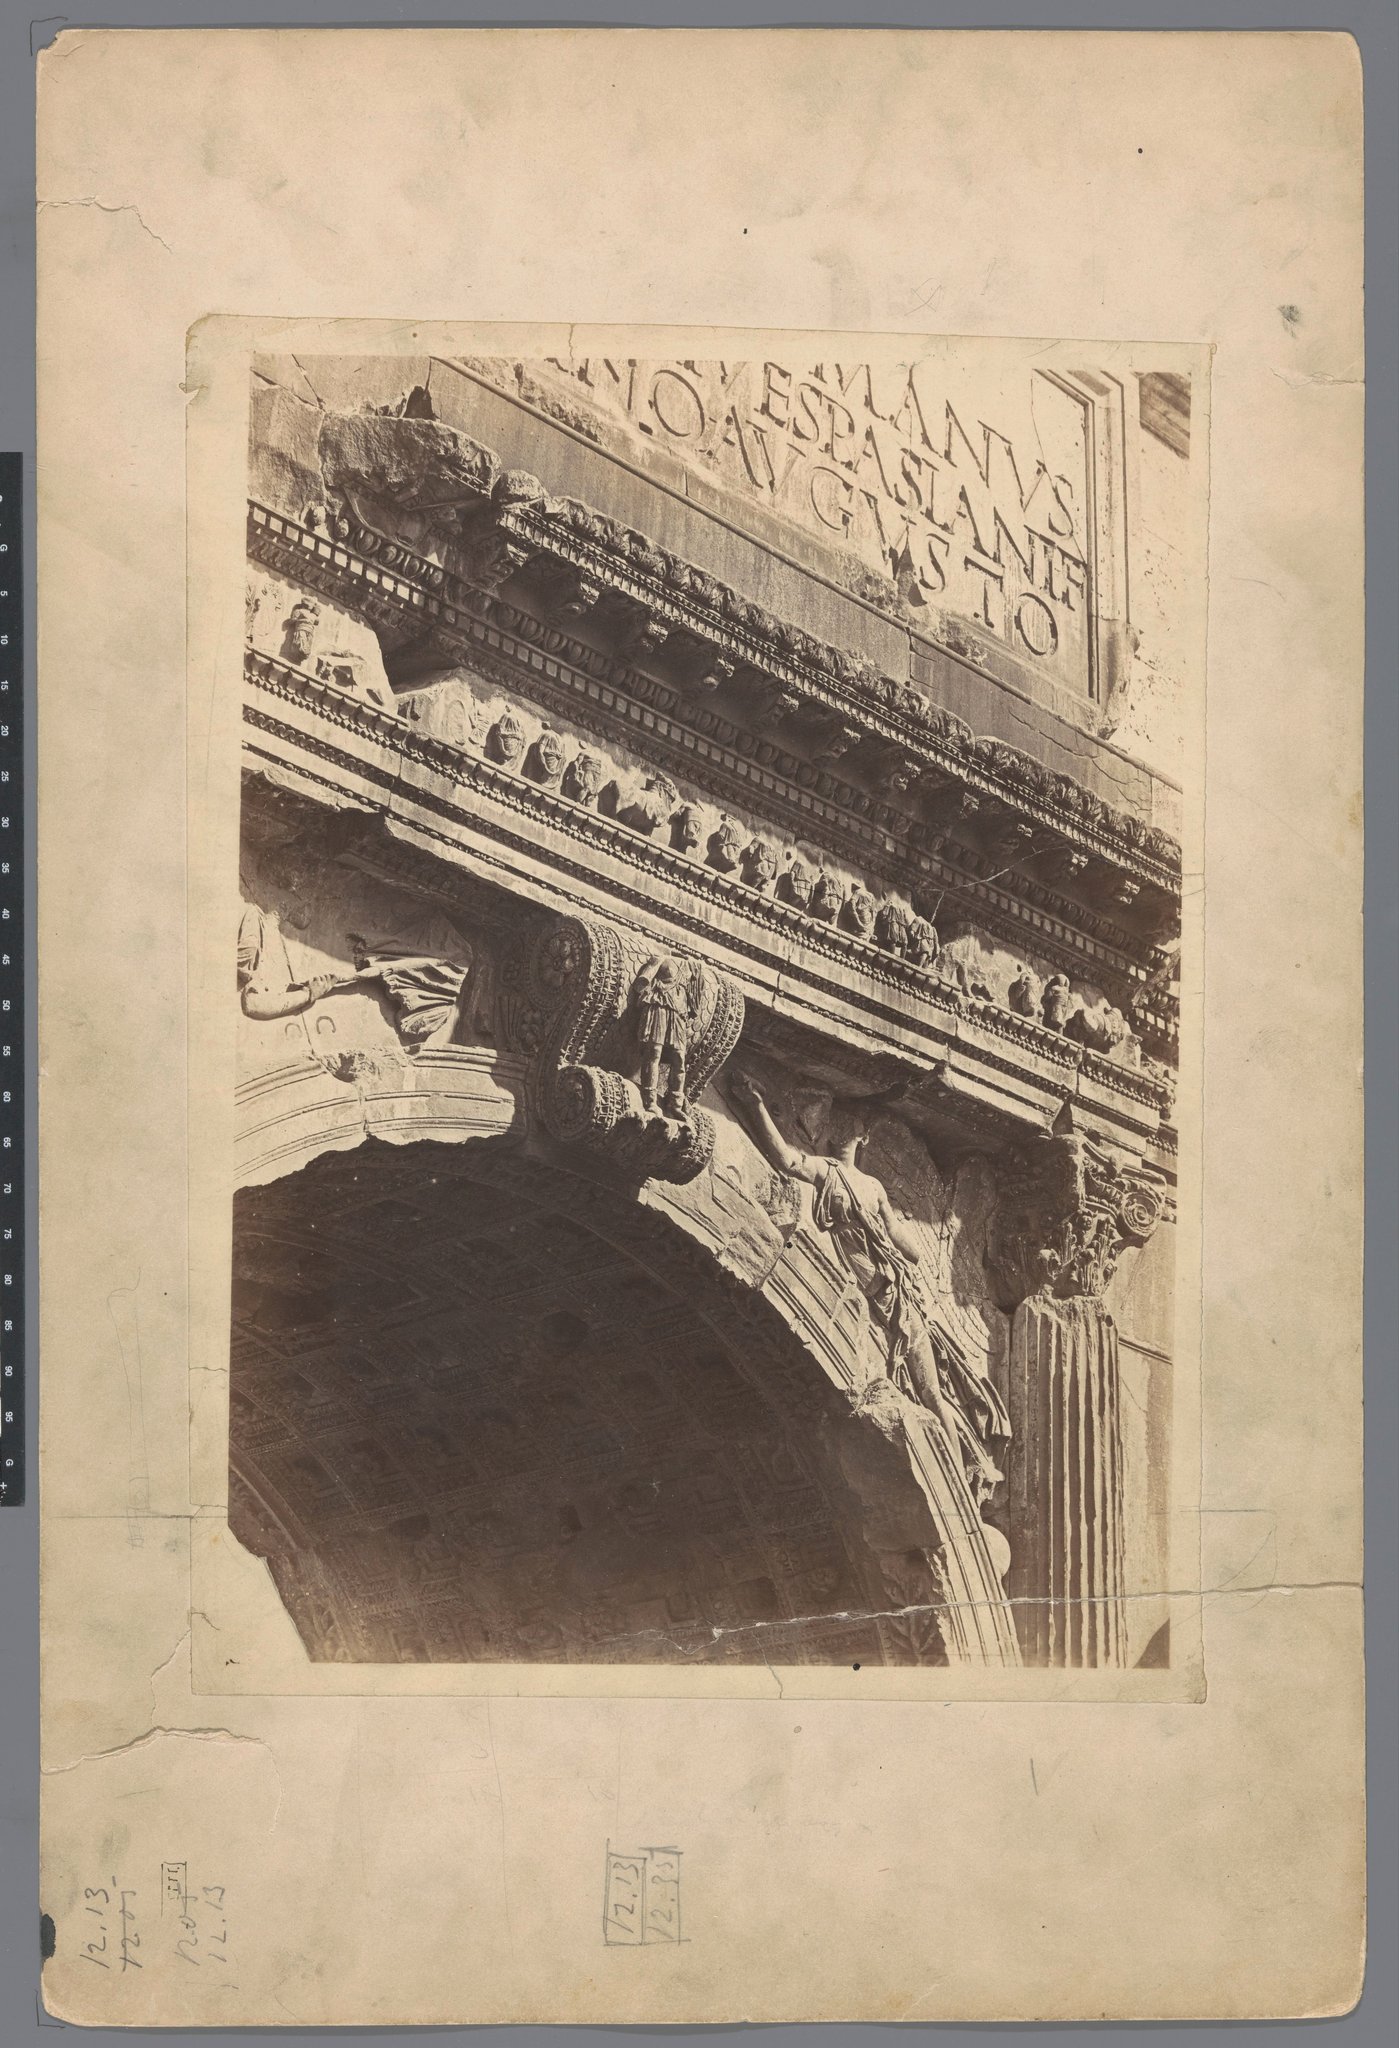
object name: photograph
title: Reliëfs op de Boog van Titus te Rome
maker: gustave eugène chauffourier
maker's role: fotograaf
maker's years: 1845-1919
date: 1875-1900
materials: photographic support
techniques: albumen print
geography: rome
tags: triumphal arch, sculpture (+ relief ~ sculpture)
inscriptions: collector's mark: Lugt 3937